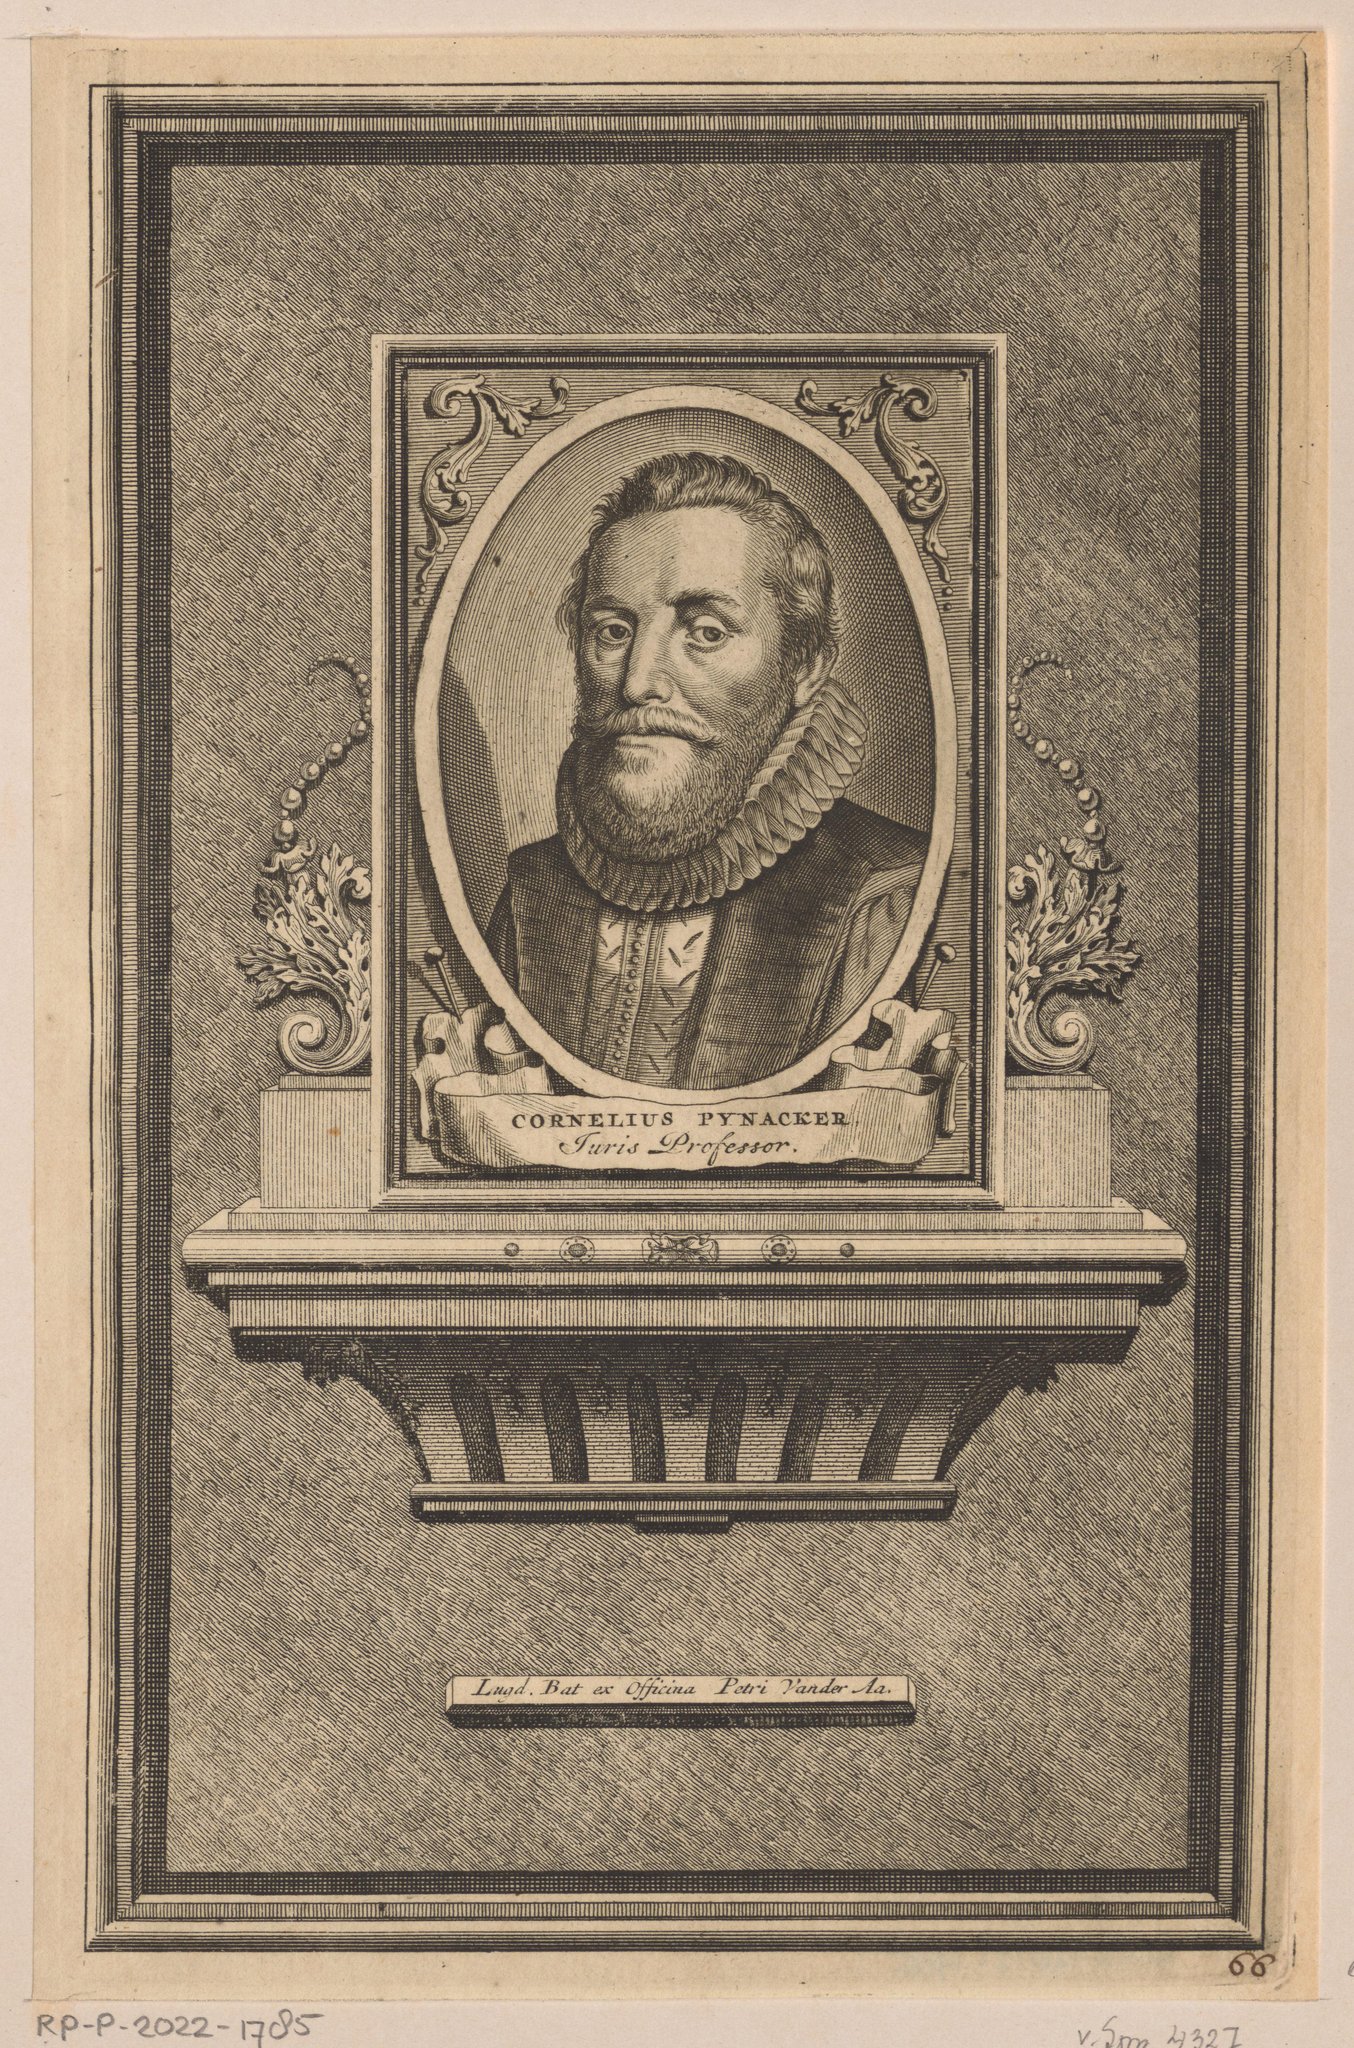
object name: print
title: Portret van Cornelis Pijnacker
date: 1720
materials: paper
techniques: engraving, etching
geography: leiden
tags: cornelis pijnacker, historical persons, professor, map making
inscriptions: number: ‘66’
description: Prent waarschijnlijk uit: Fundatoris, curatorum et professorum celeberrimorum, aliorumque illustrium virorum, quorum gratia, favore cura, doctrinaque adademia Lugduno-Batava (...). Leiden: Pieter van der Aa, 1720.